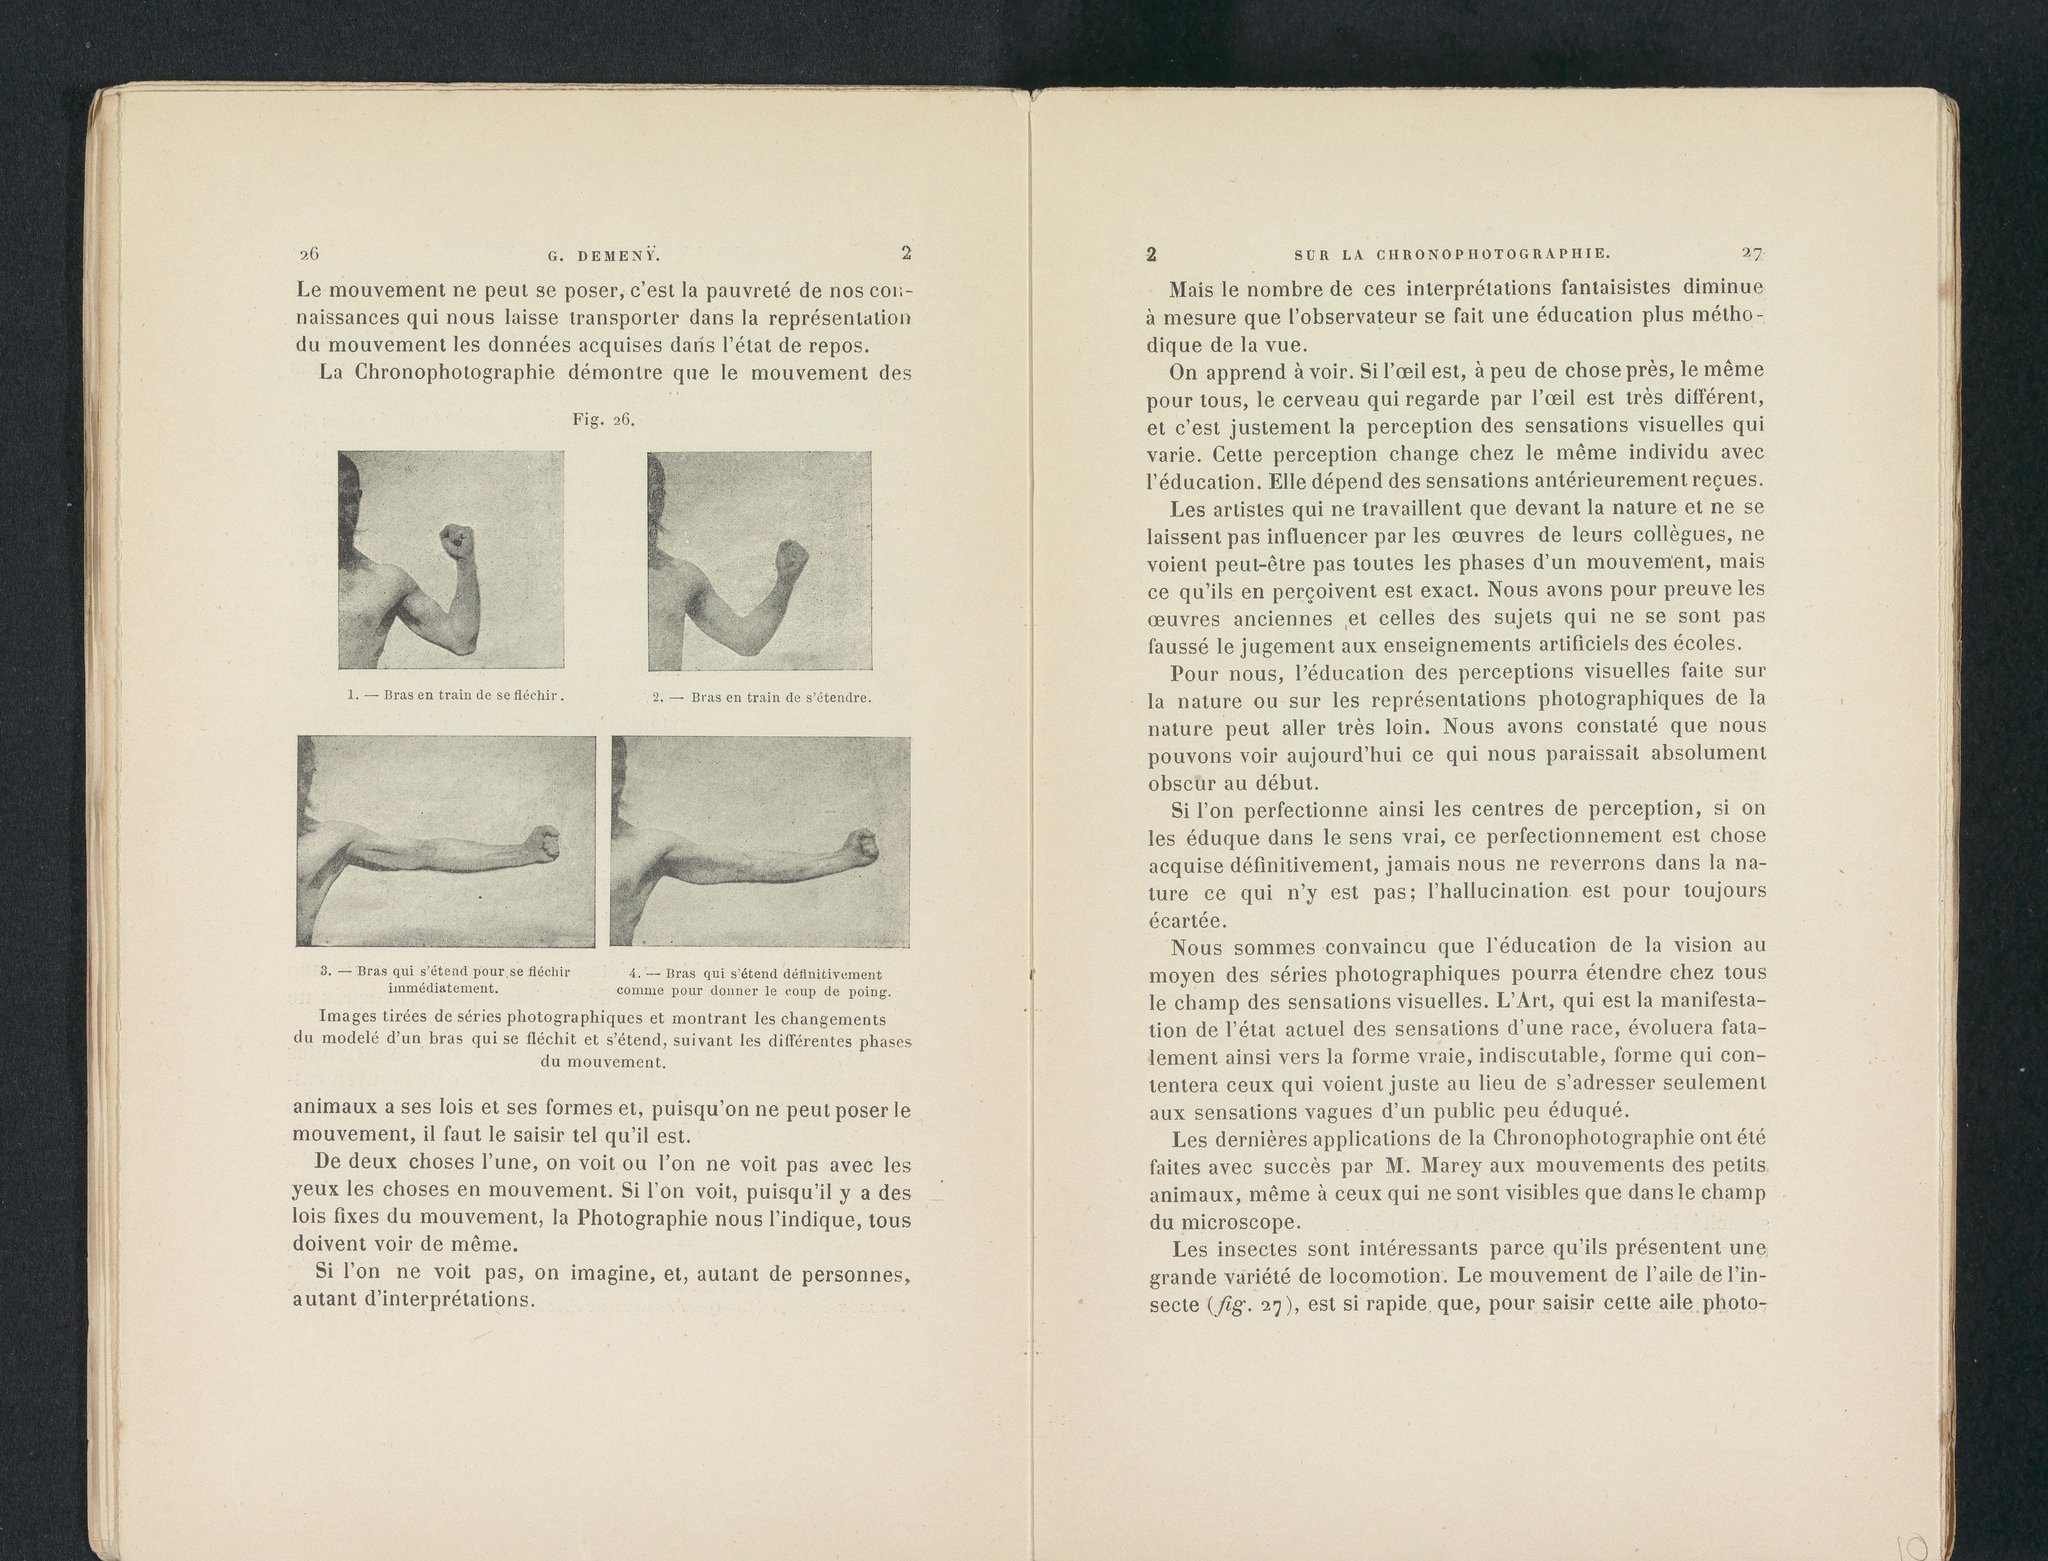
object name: photomechanical print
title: Man die zijn arm strekt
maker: Anonymous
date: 1870-1890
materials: paper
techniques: autotype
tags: arm stretched sidewards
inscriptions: number: ‘Fig. 26. (...) 4.’, inscription: ‘Bras en train (...) le coup de poing.’